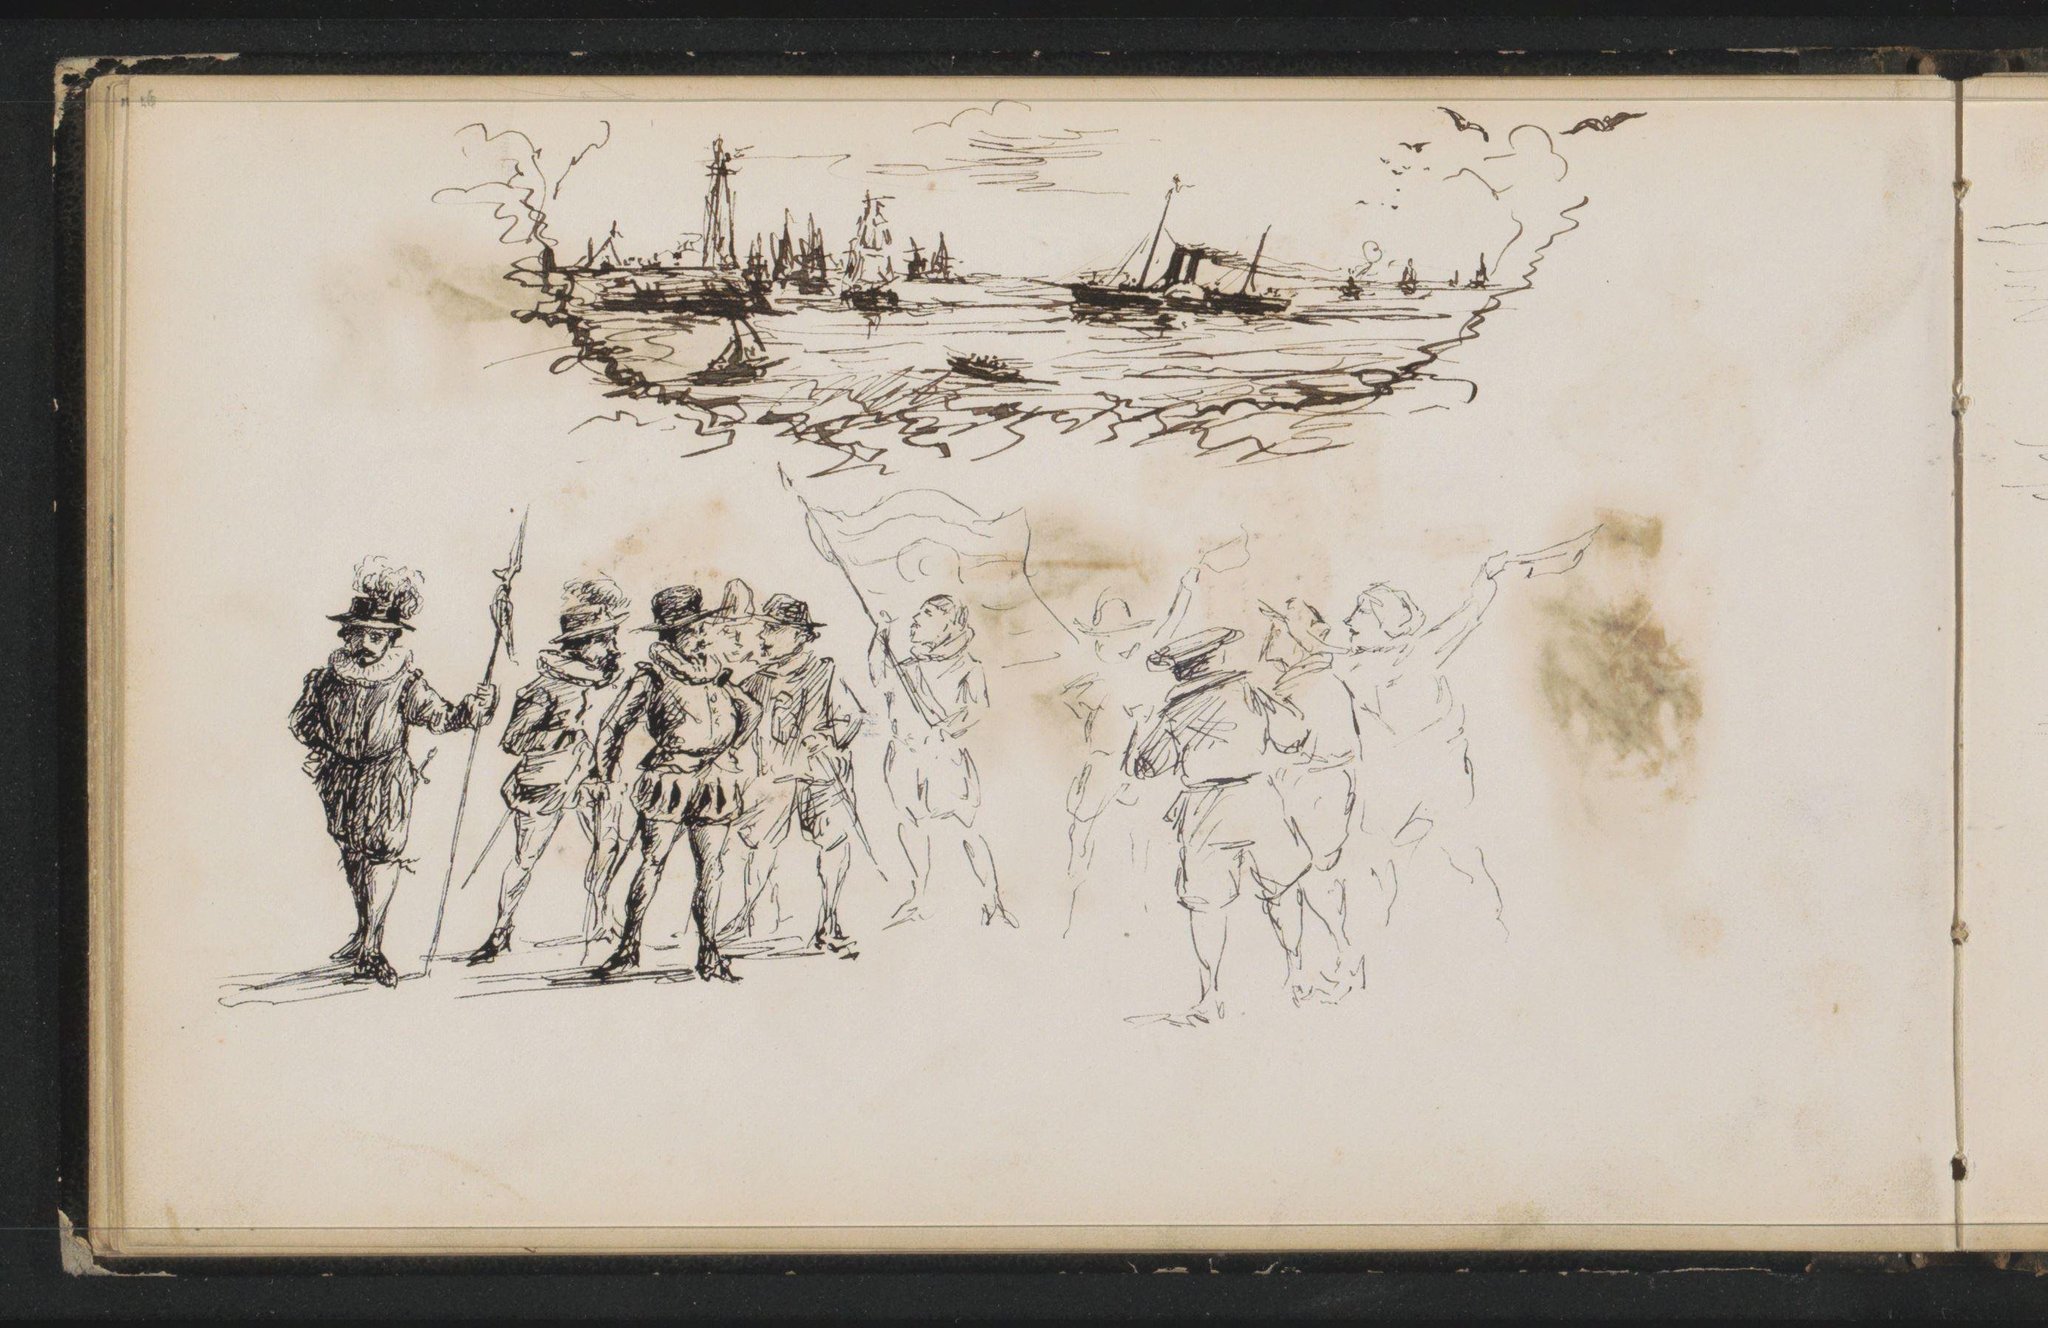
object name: sketchbook leaf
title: Studieblad, onder andere met zeilschepen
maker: marius bauer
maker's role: draughtsman, print maker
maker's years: 1867-1932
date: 1812-1880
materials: paper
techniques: pen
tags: sailing-ship, sailing-boat, landscapes with waters, waterscapes, seascapes (in the temperate zone), (military) standard-bearer, historical costume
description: Tevens een studie van een militie in zeventiende-eeuws kostuum met een vaandeldrager. Pagina 16 uit een schetsboek met 34 bladen.